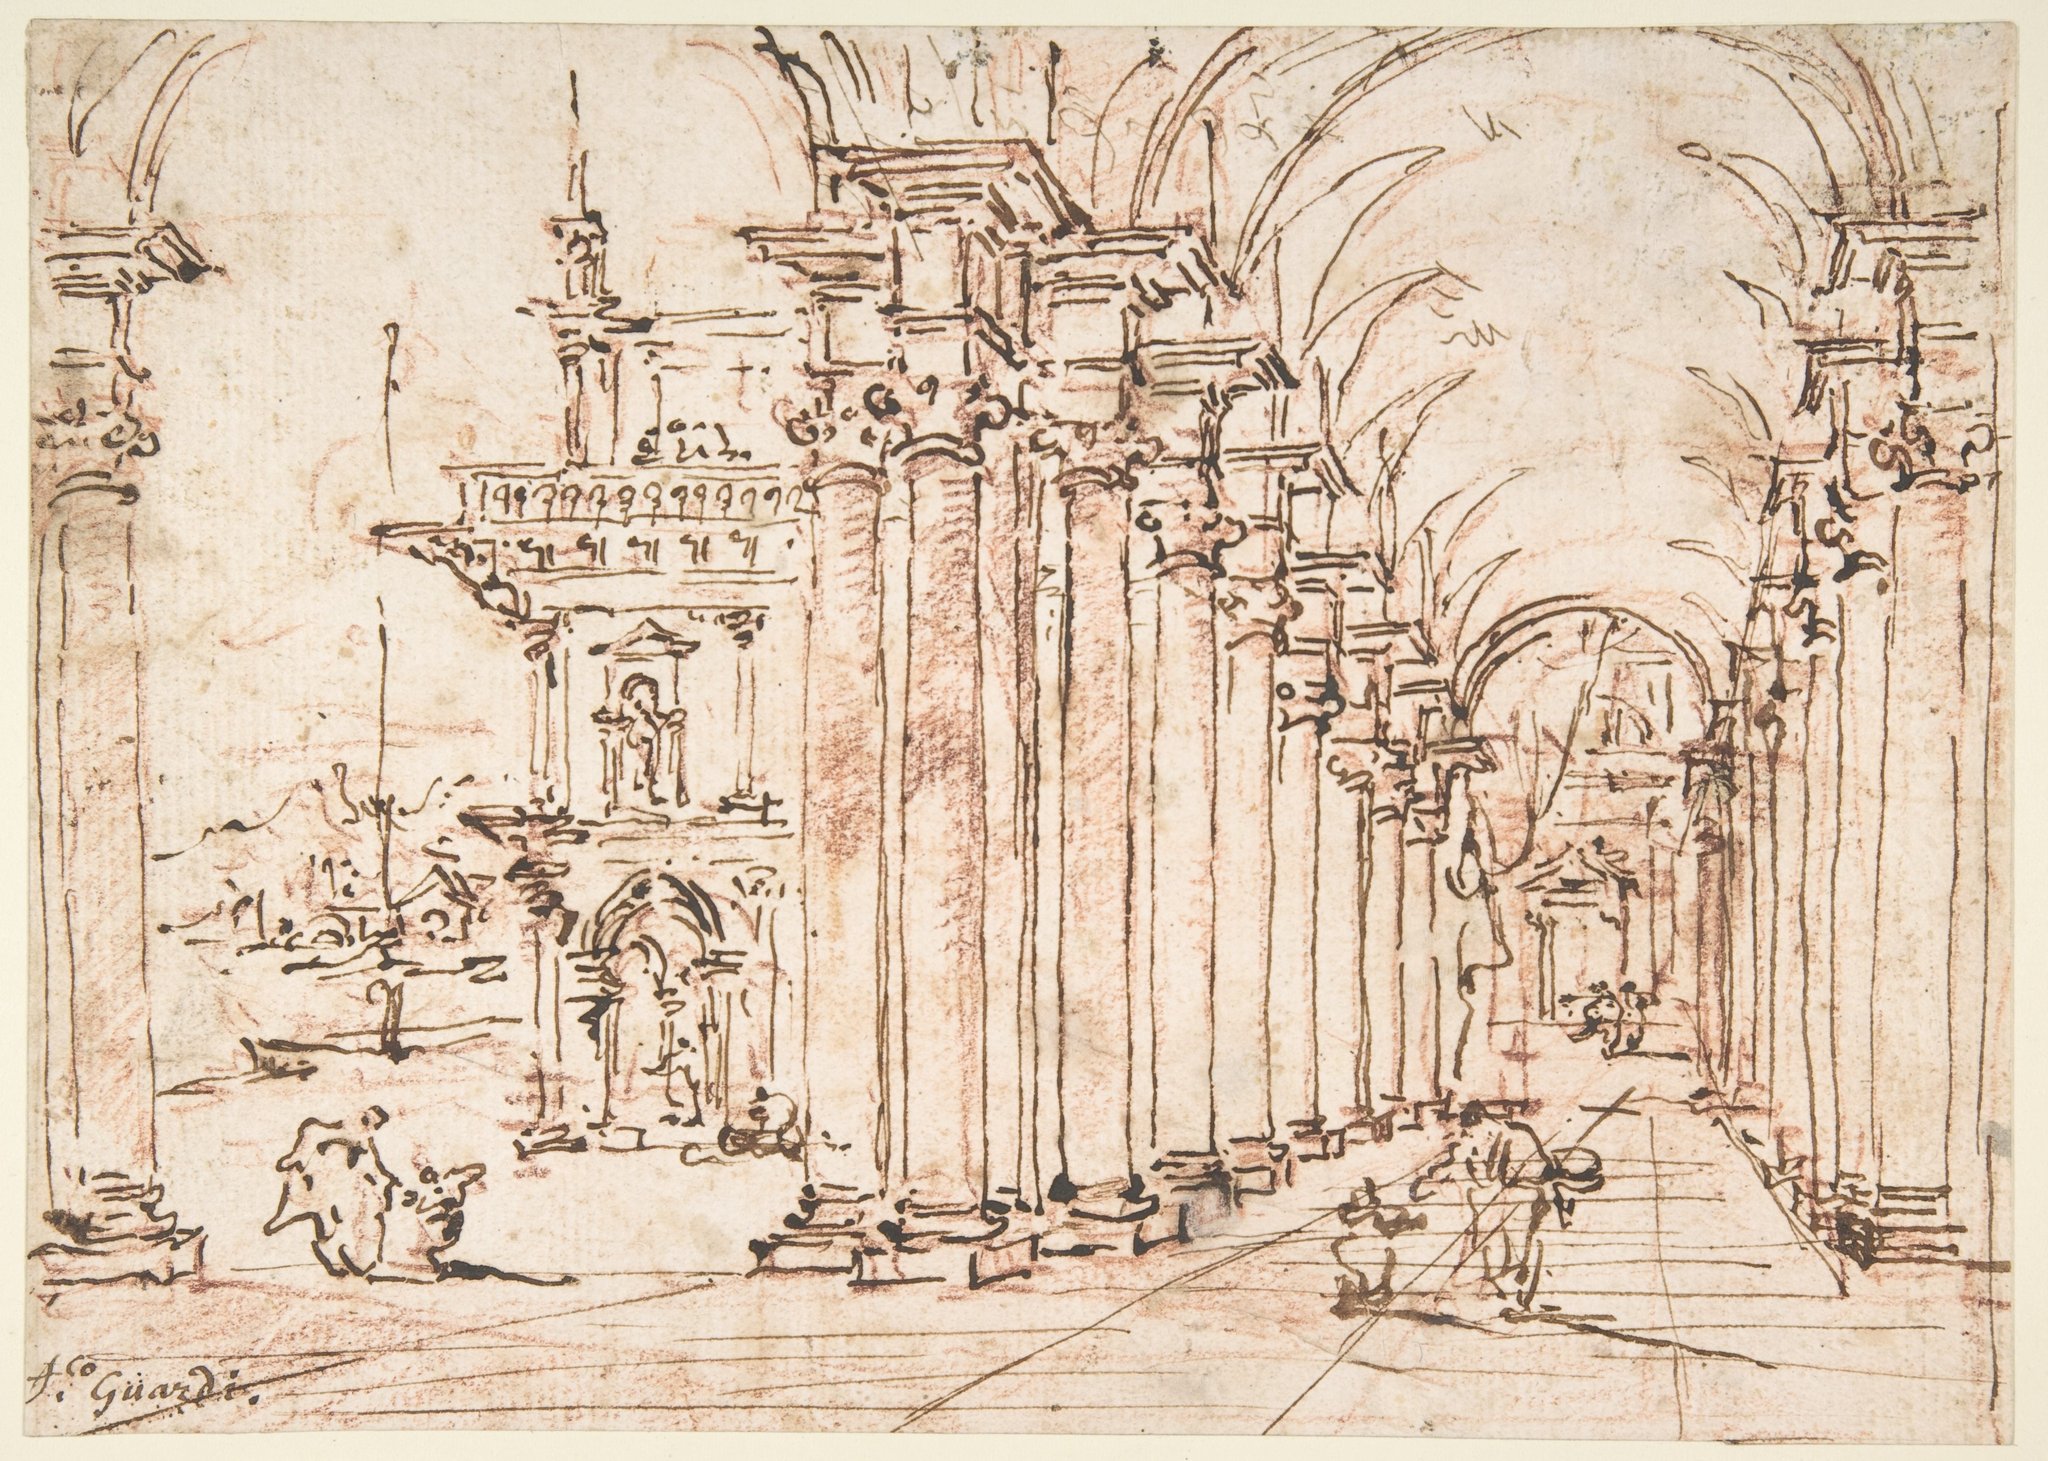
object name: drawing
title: Architectural Capriccio: Vaulted Colonnade of a Palace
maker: francesco guardi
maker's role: artist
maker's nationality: italian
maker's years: 1712-1793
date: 1712-1793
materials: chalk, ink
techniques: pen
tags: architecture,columns